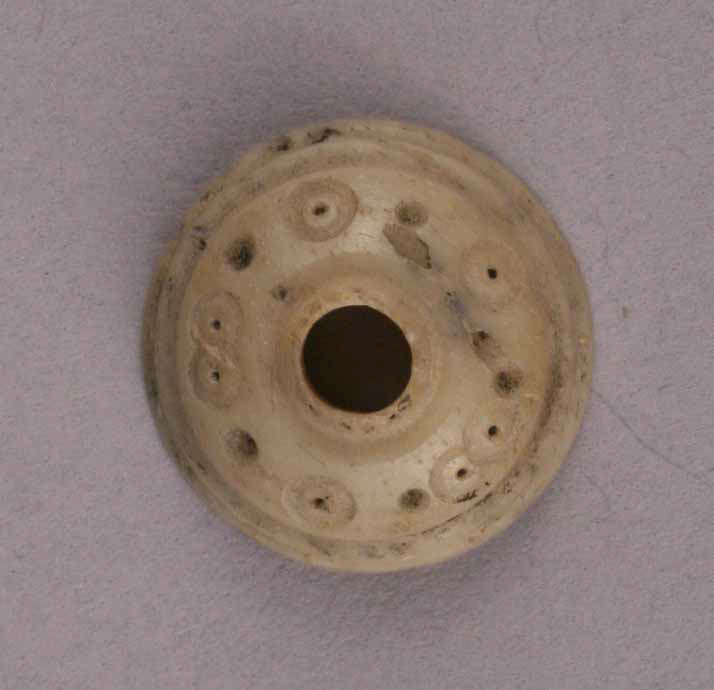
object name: button or bead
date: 801-1000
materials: bone, paint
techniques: incising, inlay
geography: iran